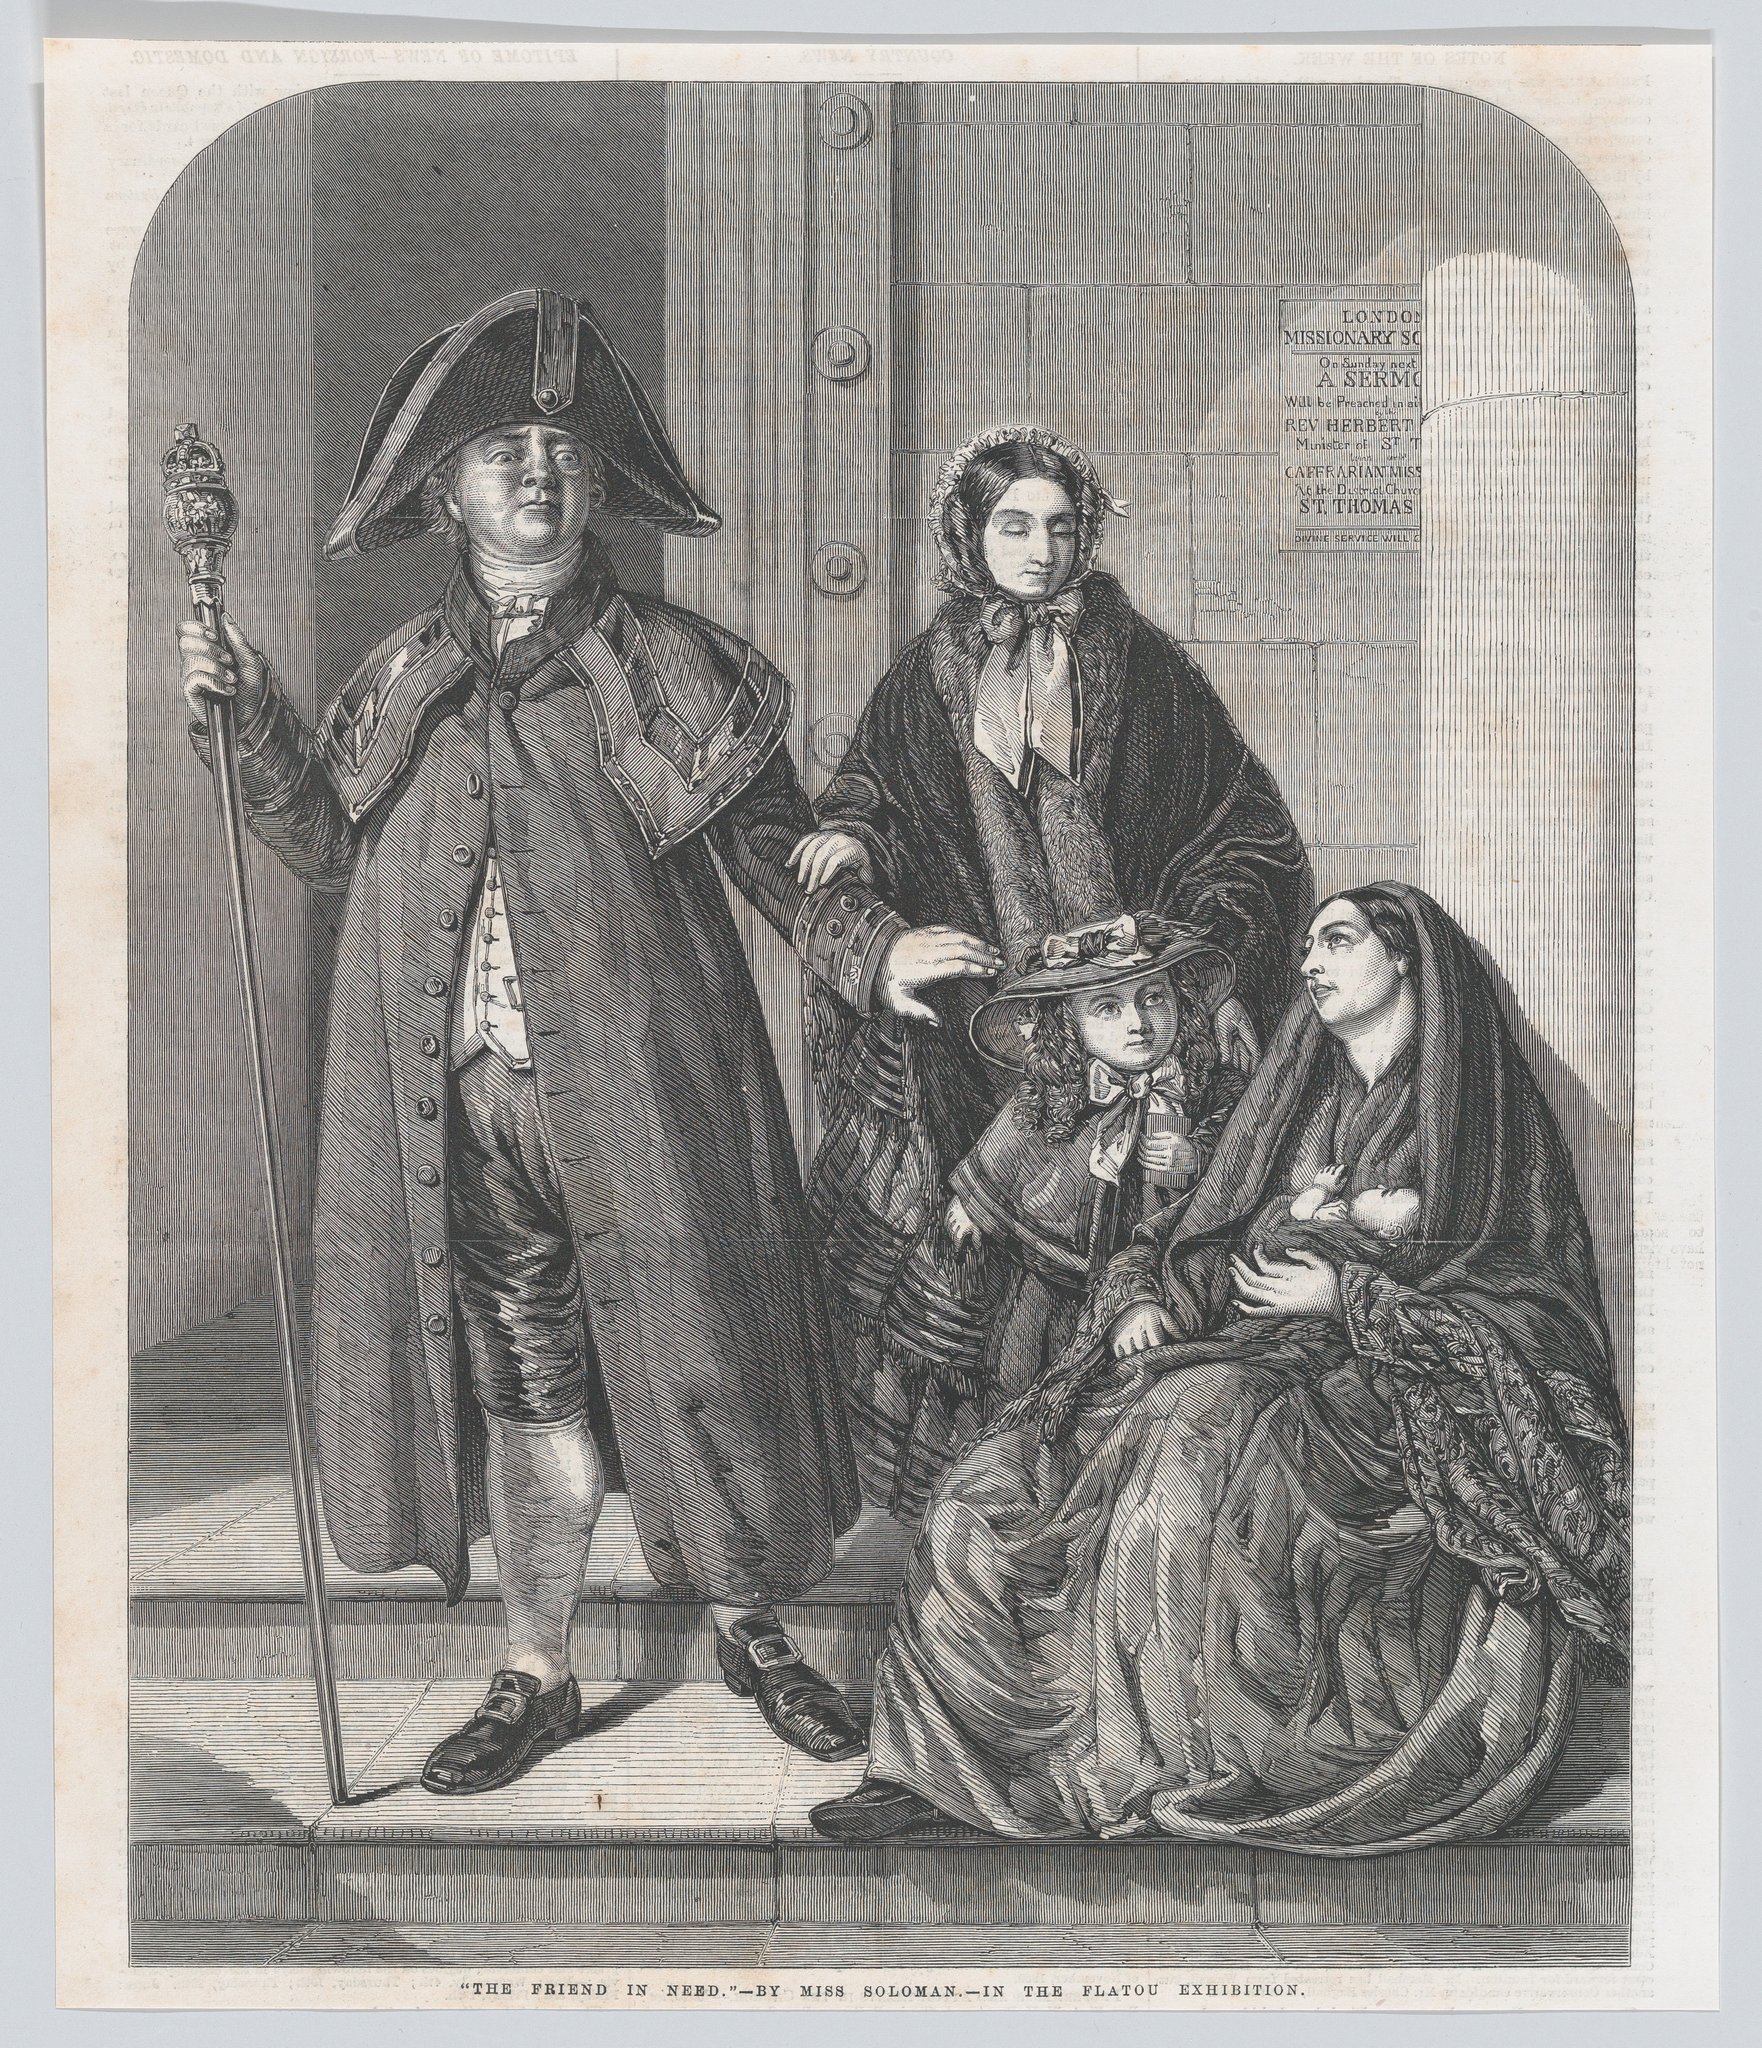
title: The Friend in Need, from "Illustrated London News"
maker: rebecca solomon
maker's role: artist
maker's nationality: british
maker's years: 1832-1886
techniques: engraving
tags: girls,infants,men,mothers,women